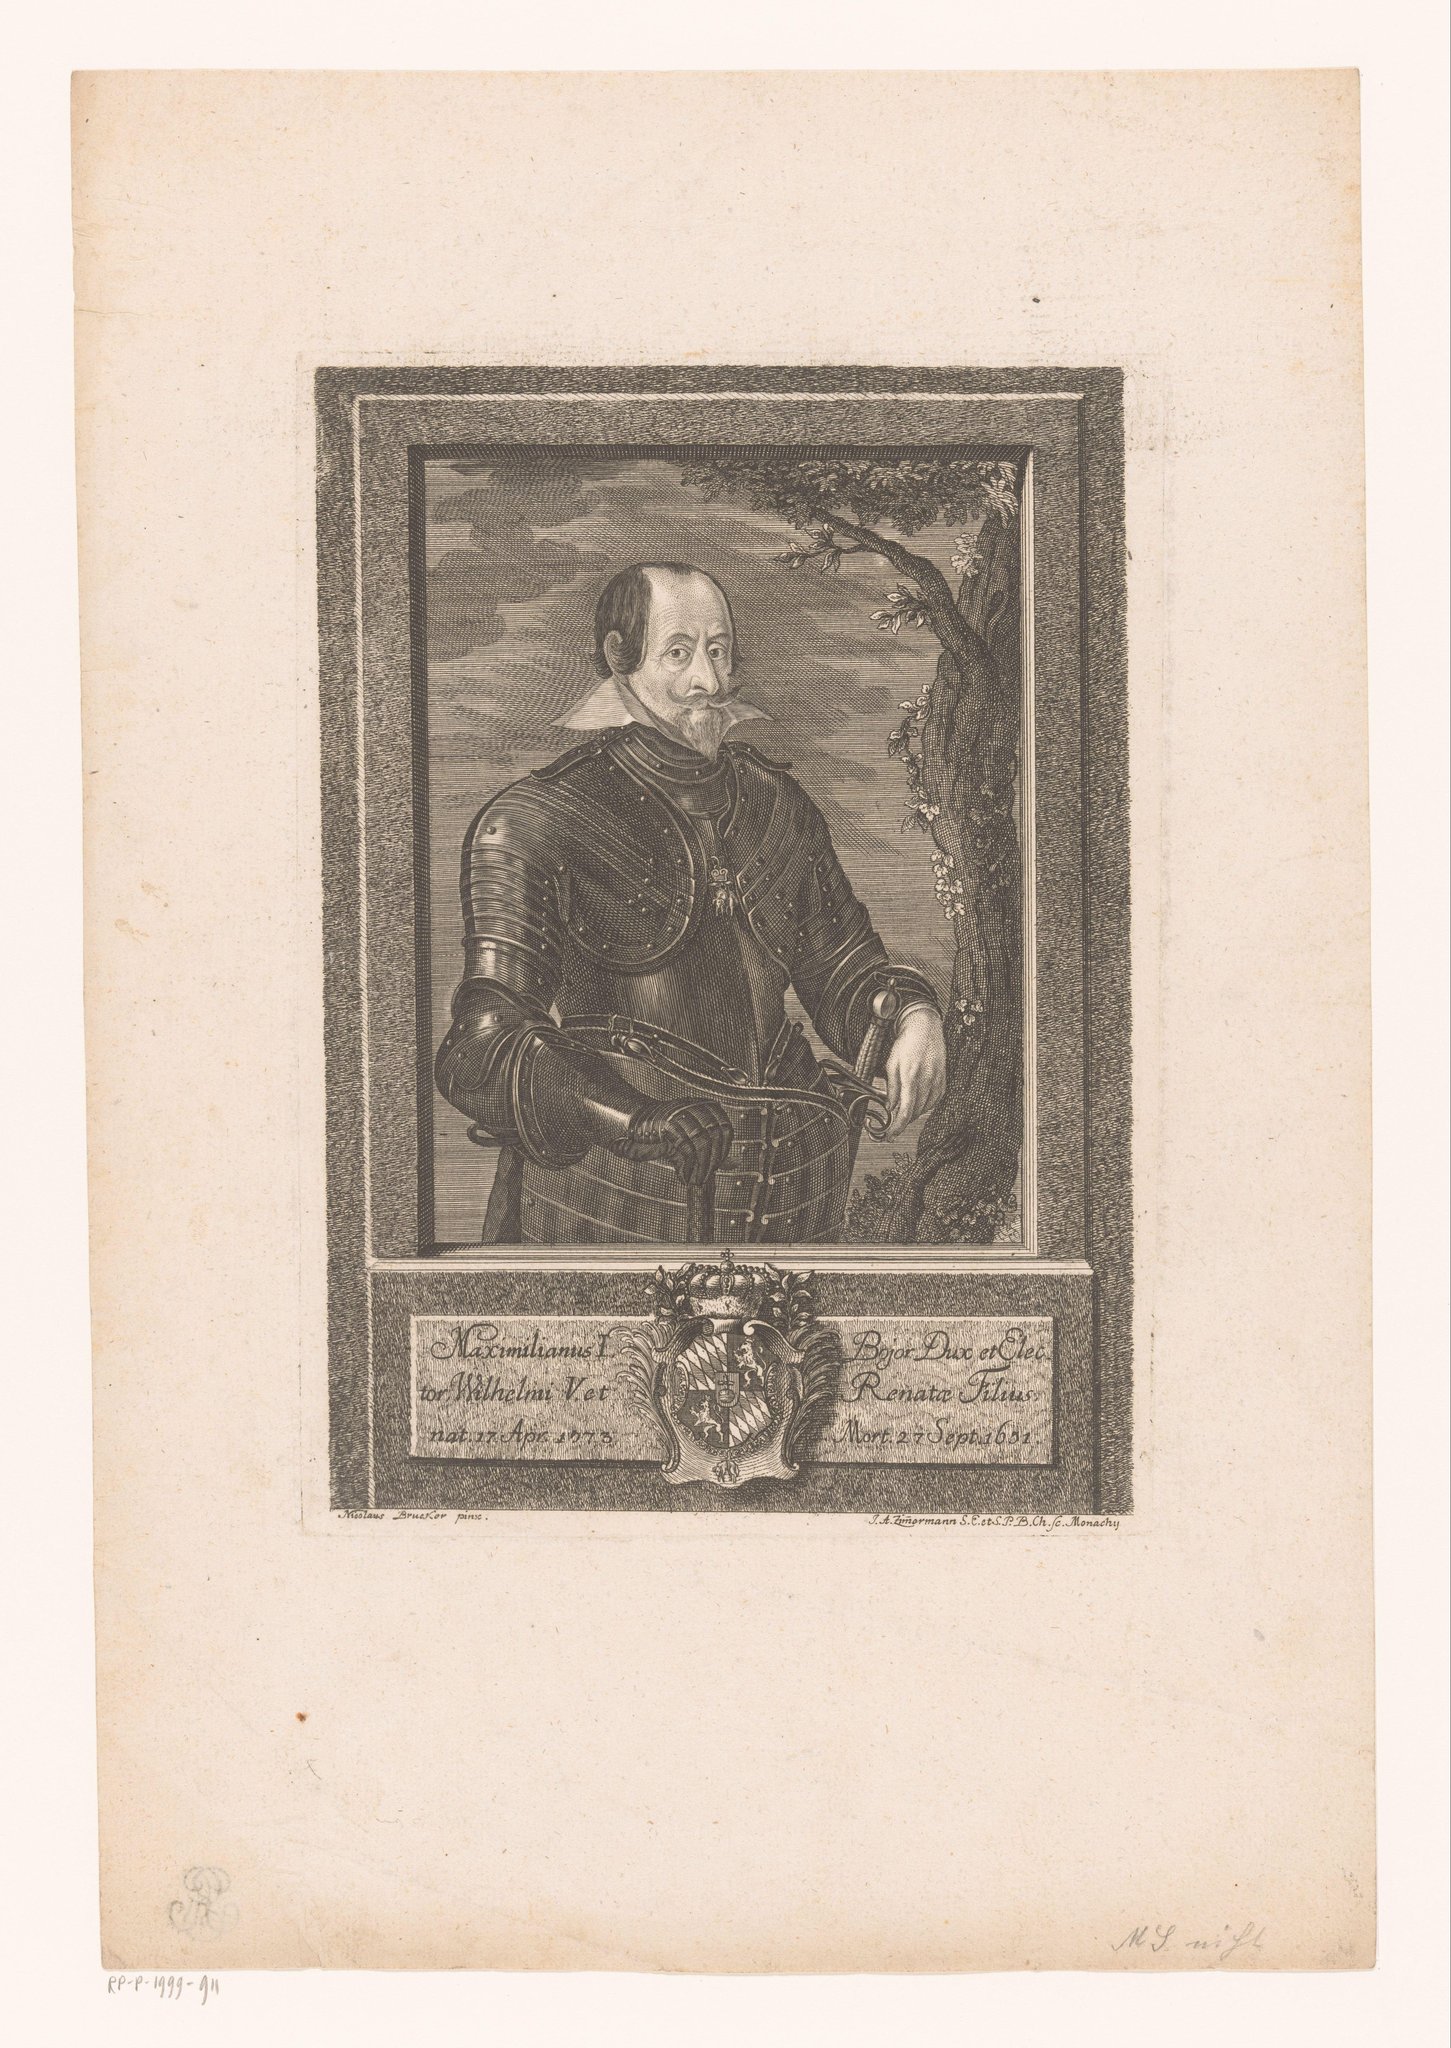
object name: print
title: Portret Maximiliaan I van Beieren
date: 1773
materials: paper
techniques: engraving, etching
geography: munich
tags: maximiliaan i (keurvorst van beieren), historical persons, knighthood order of the golden fleece - insignia of a knighthood order, e.g.: badge, chain (with name of order)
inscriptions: collector's mark: Lugt 4100, collector's mark: Lugt 2760, collector's mark: Lugt 2228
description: Prent gebruikt voor de publicatie: Zimmermann, Joseph Anton. Series Imaginum Augustae Domus Boicae. München: s.n., 1773.